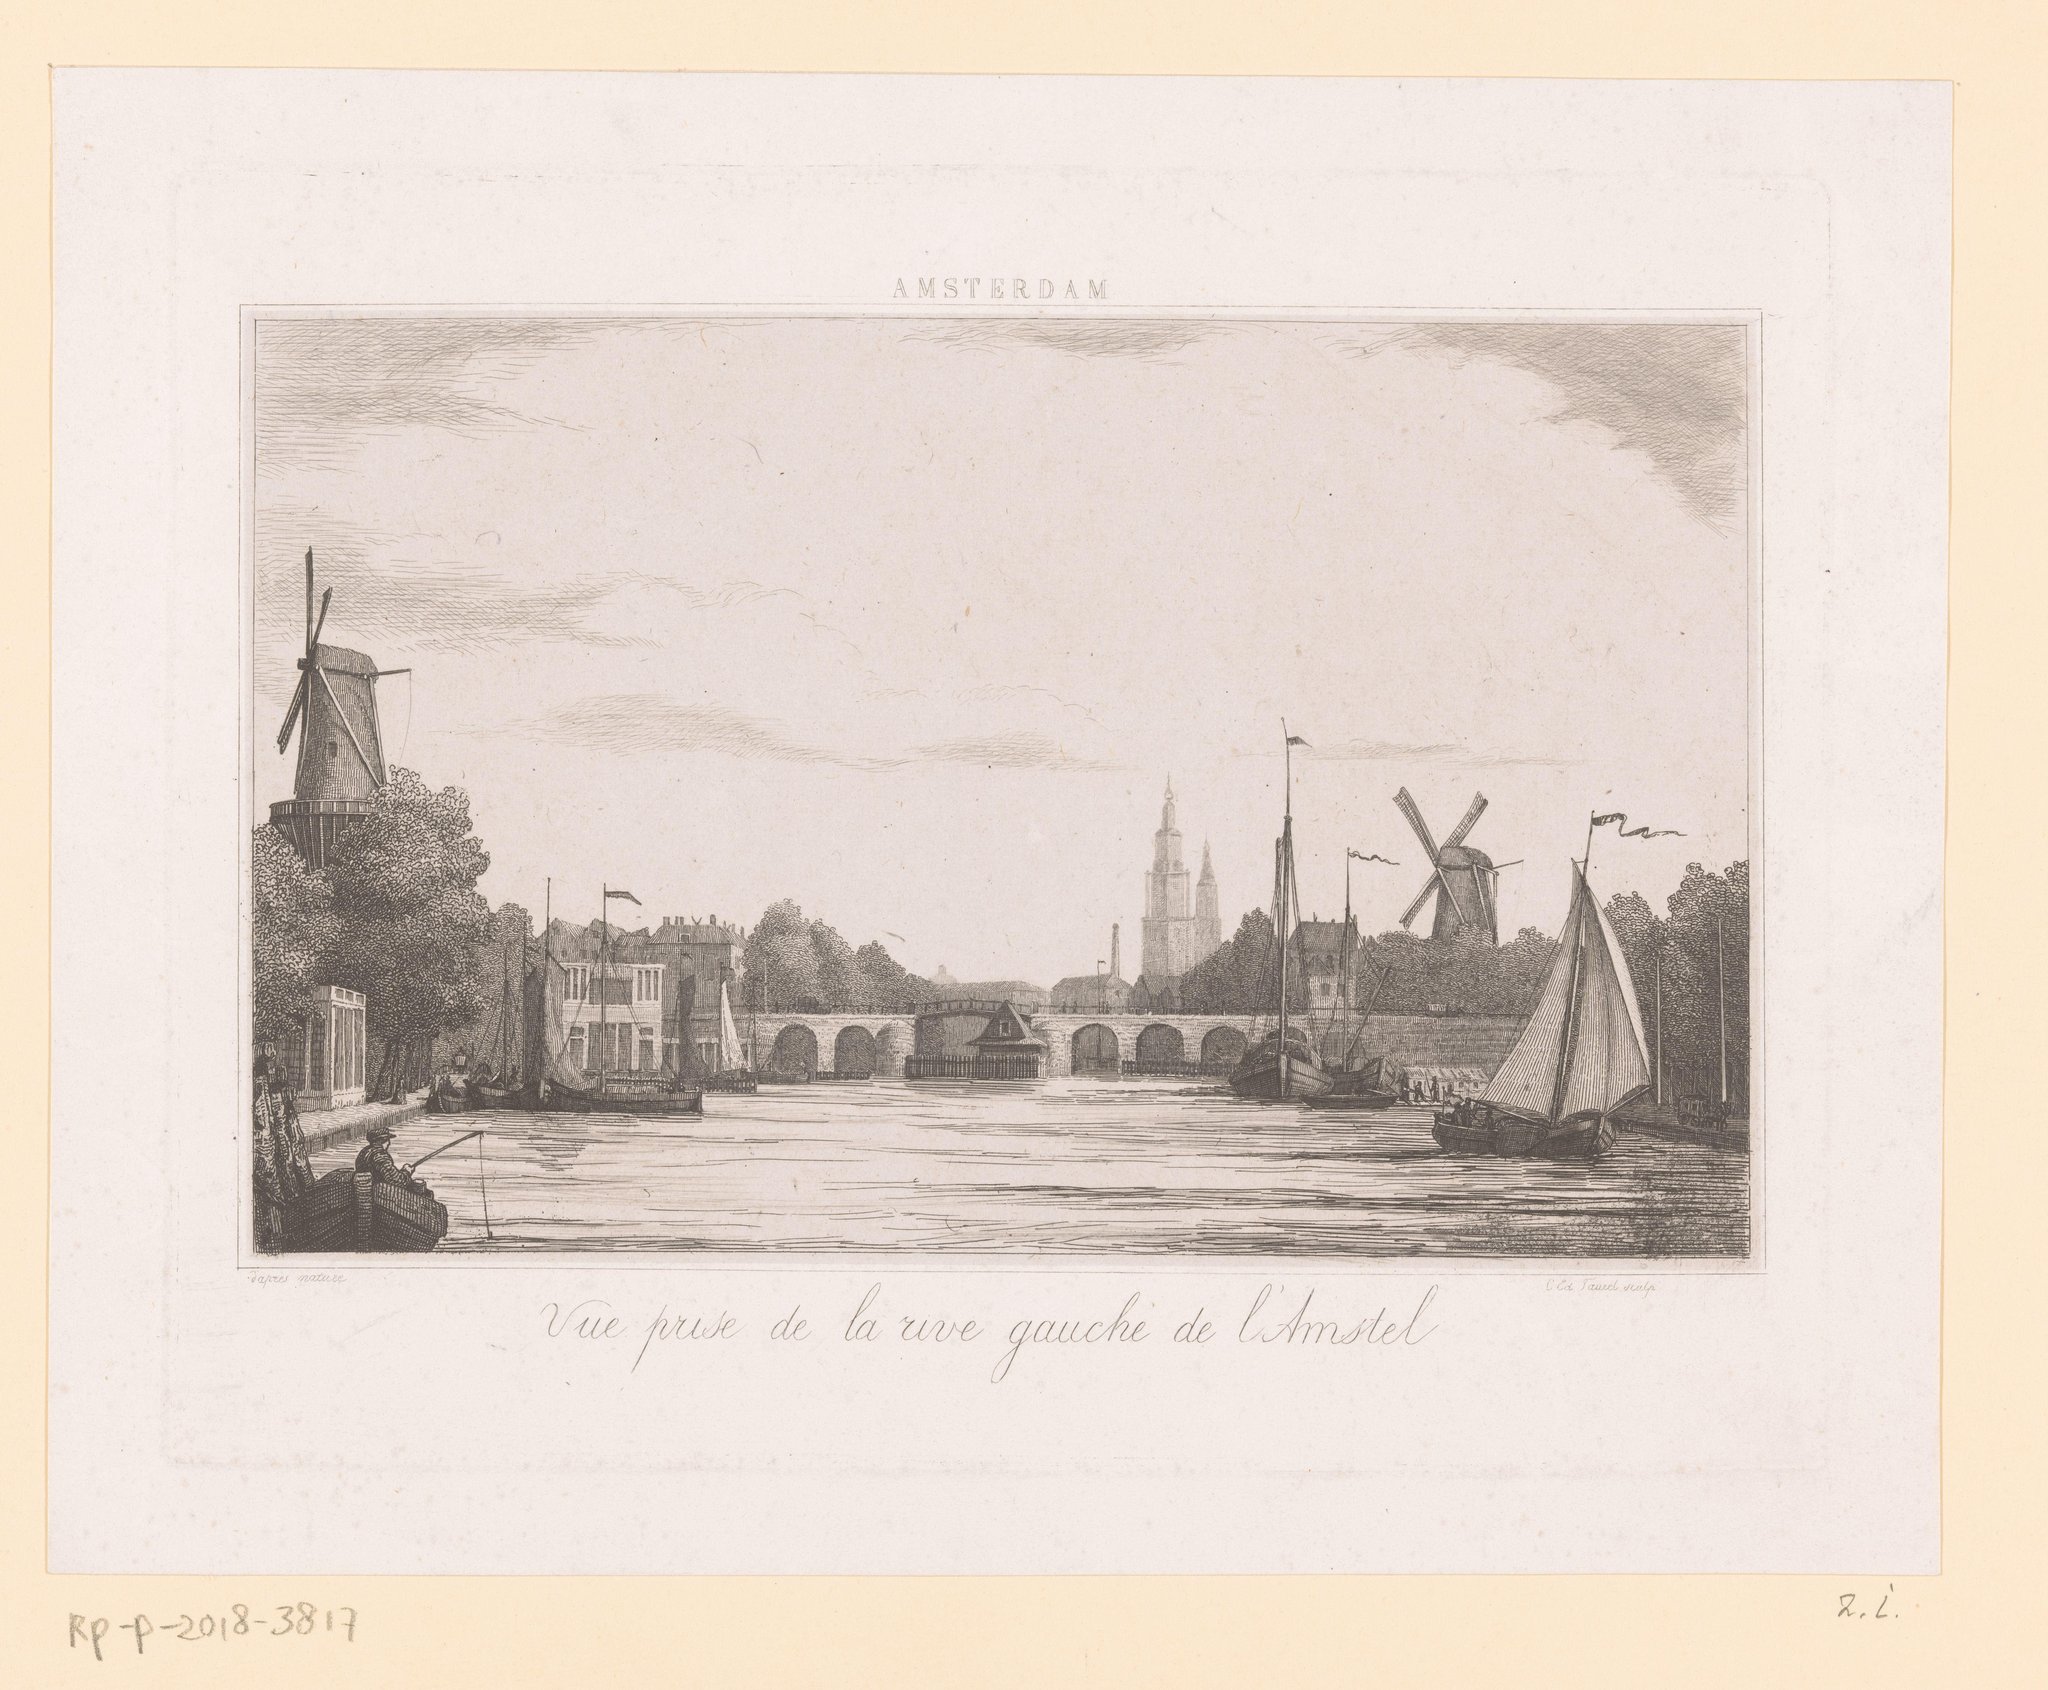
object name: print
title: Vue prise de la rive gauche de l'Amstel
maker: edouard taurel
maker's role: draughtsman, print maker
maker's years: 1824-1892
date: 1834-1883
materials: paper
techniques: etching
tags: canals, waters (in city), bridge in city across river, canal, etc., windmill